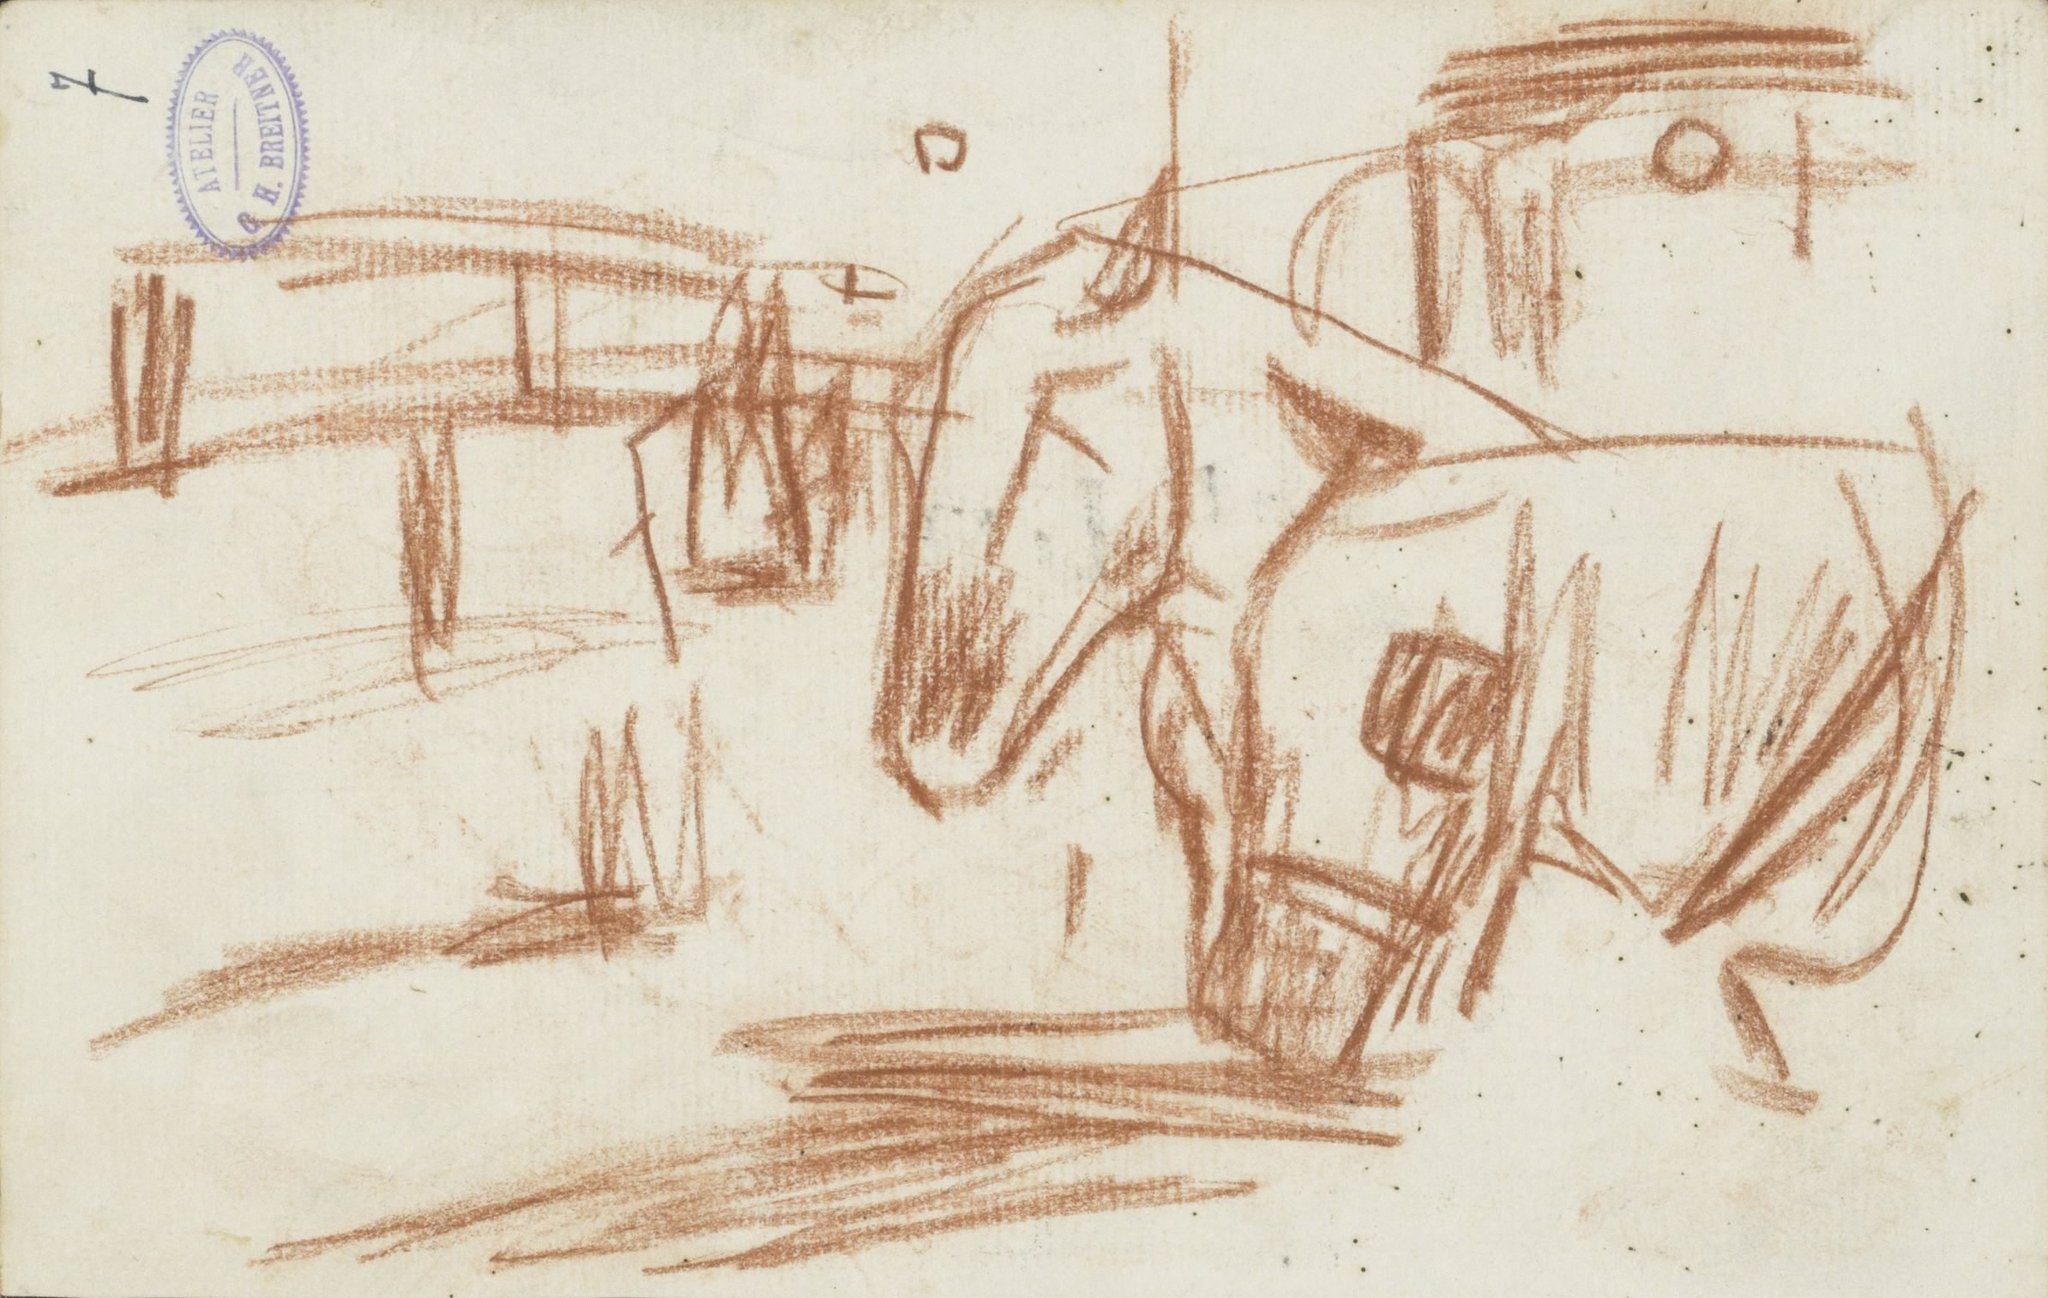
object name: drawing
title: Stadsgezicht met twee aangespannen paarden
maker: george hendrik breitner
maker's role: draughtsman, painter, print maker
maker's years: 1857-1923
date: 1888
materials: chalk, paper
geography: amsterdam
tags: four-wheeled, animal-drawn vehicle, e.g.: cab, carriage, coach, horse, bridge in city across river, canal, etc., amsterdam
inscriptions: workshop stamp: Lugt 291d, collector's mark: Lugt 2228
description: Links een brug en achter de paarden een rijtuig.